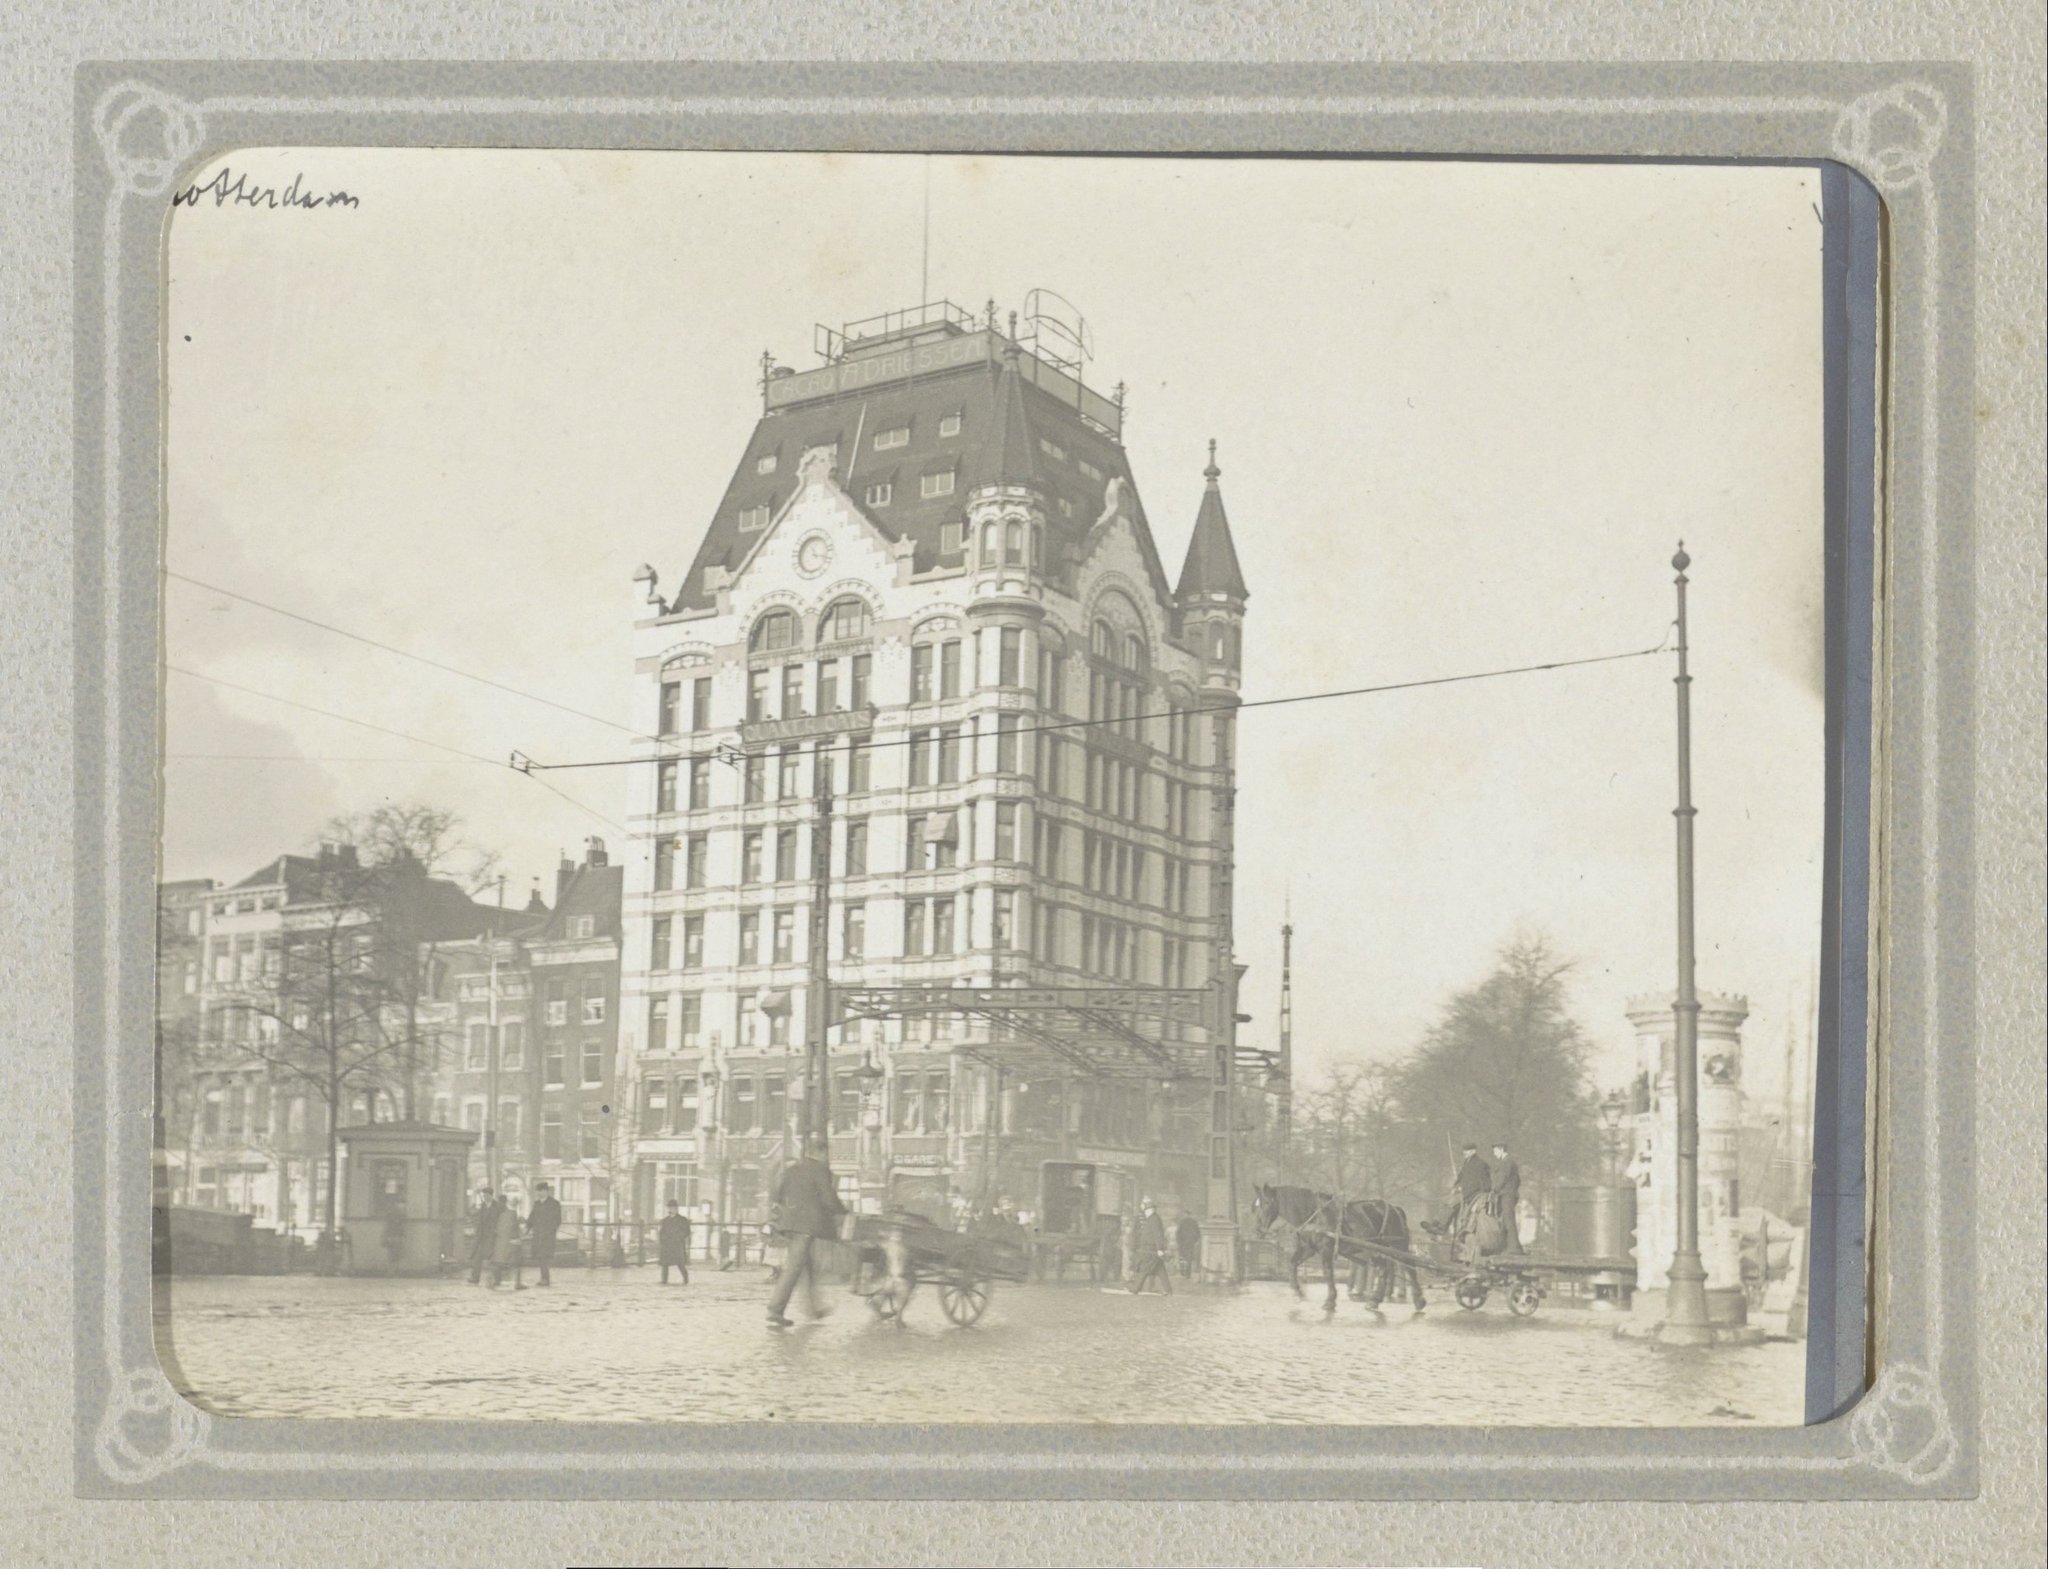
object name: photograph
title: Rotterdam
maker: folkert idzes de jong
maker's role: architect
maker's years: 1877-1929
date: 1905-1907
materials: photographic support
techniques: gelatin silver print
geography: rotterdam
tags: hand-cart, city-view, and landscape with man-made constructions, skyscraper, four-wheeled, animal-drawn vehicle, e.g.: cab, carriage, coach (+ conveyance for transport of persons)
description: Onderdeel van Topografisch album van Nederlandse dorpen en steden 1905.